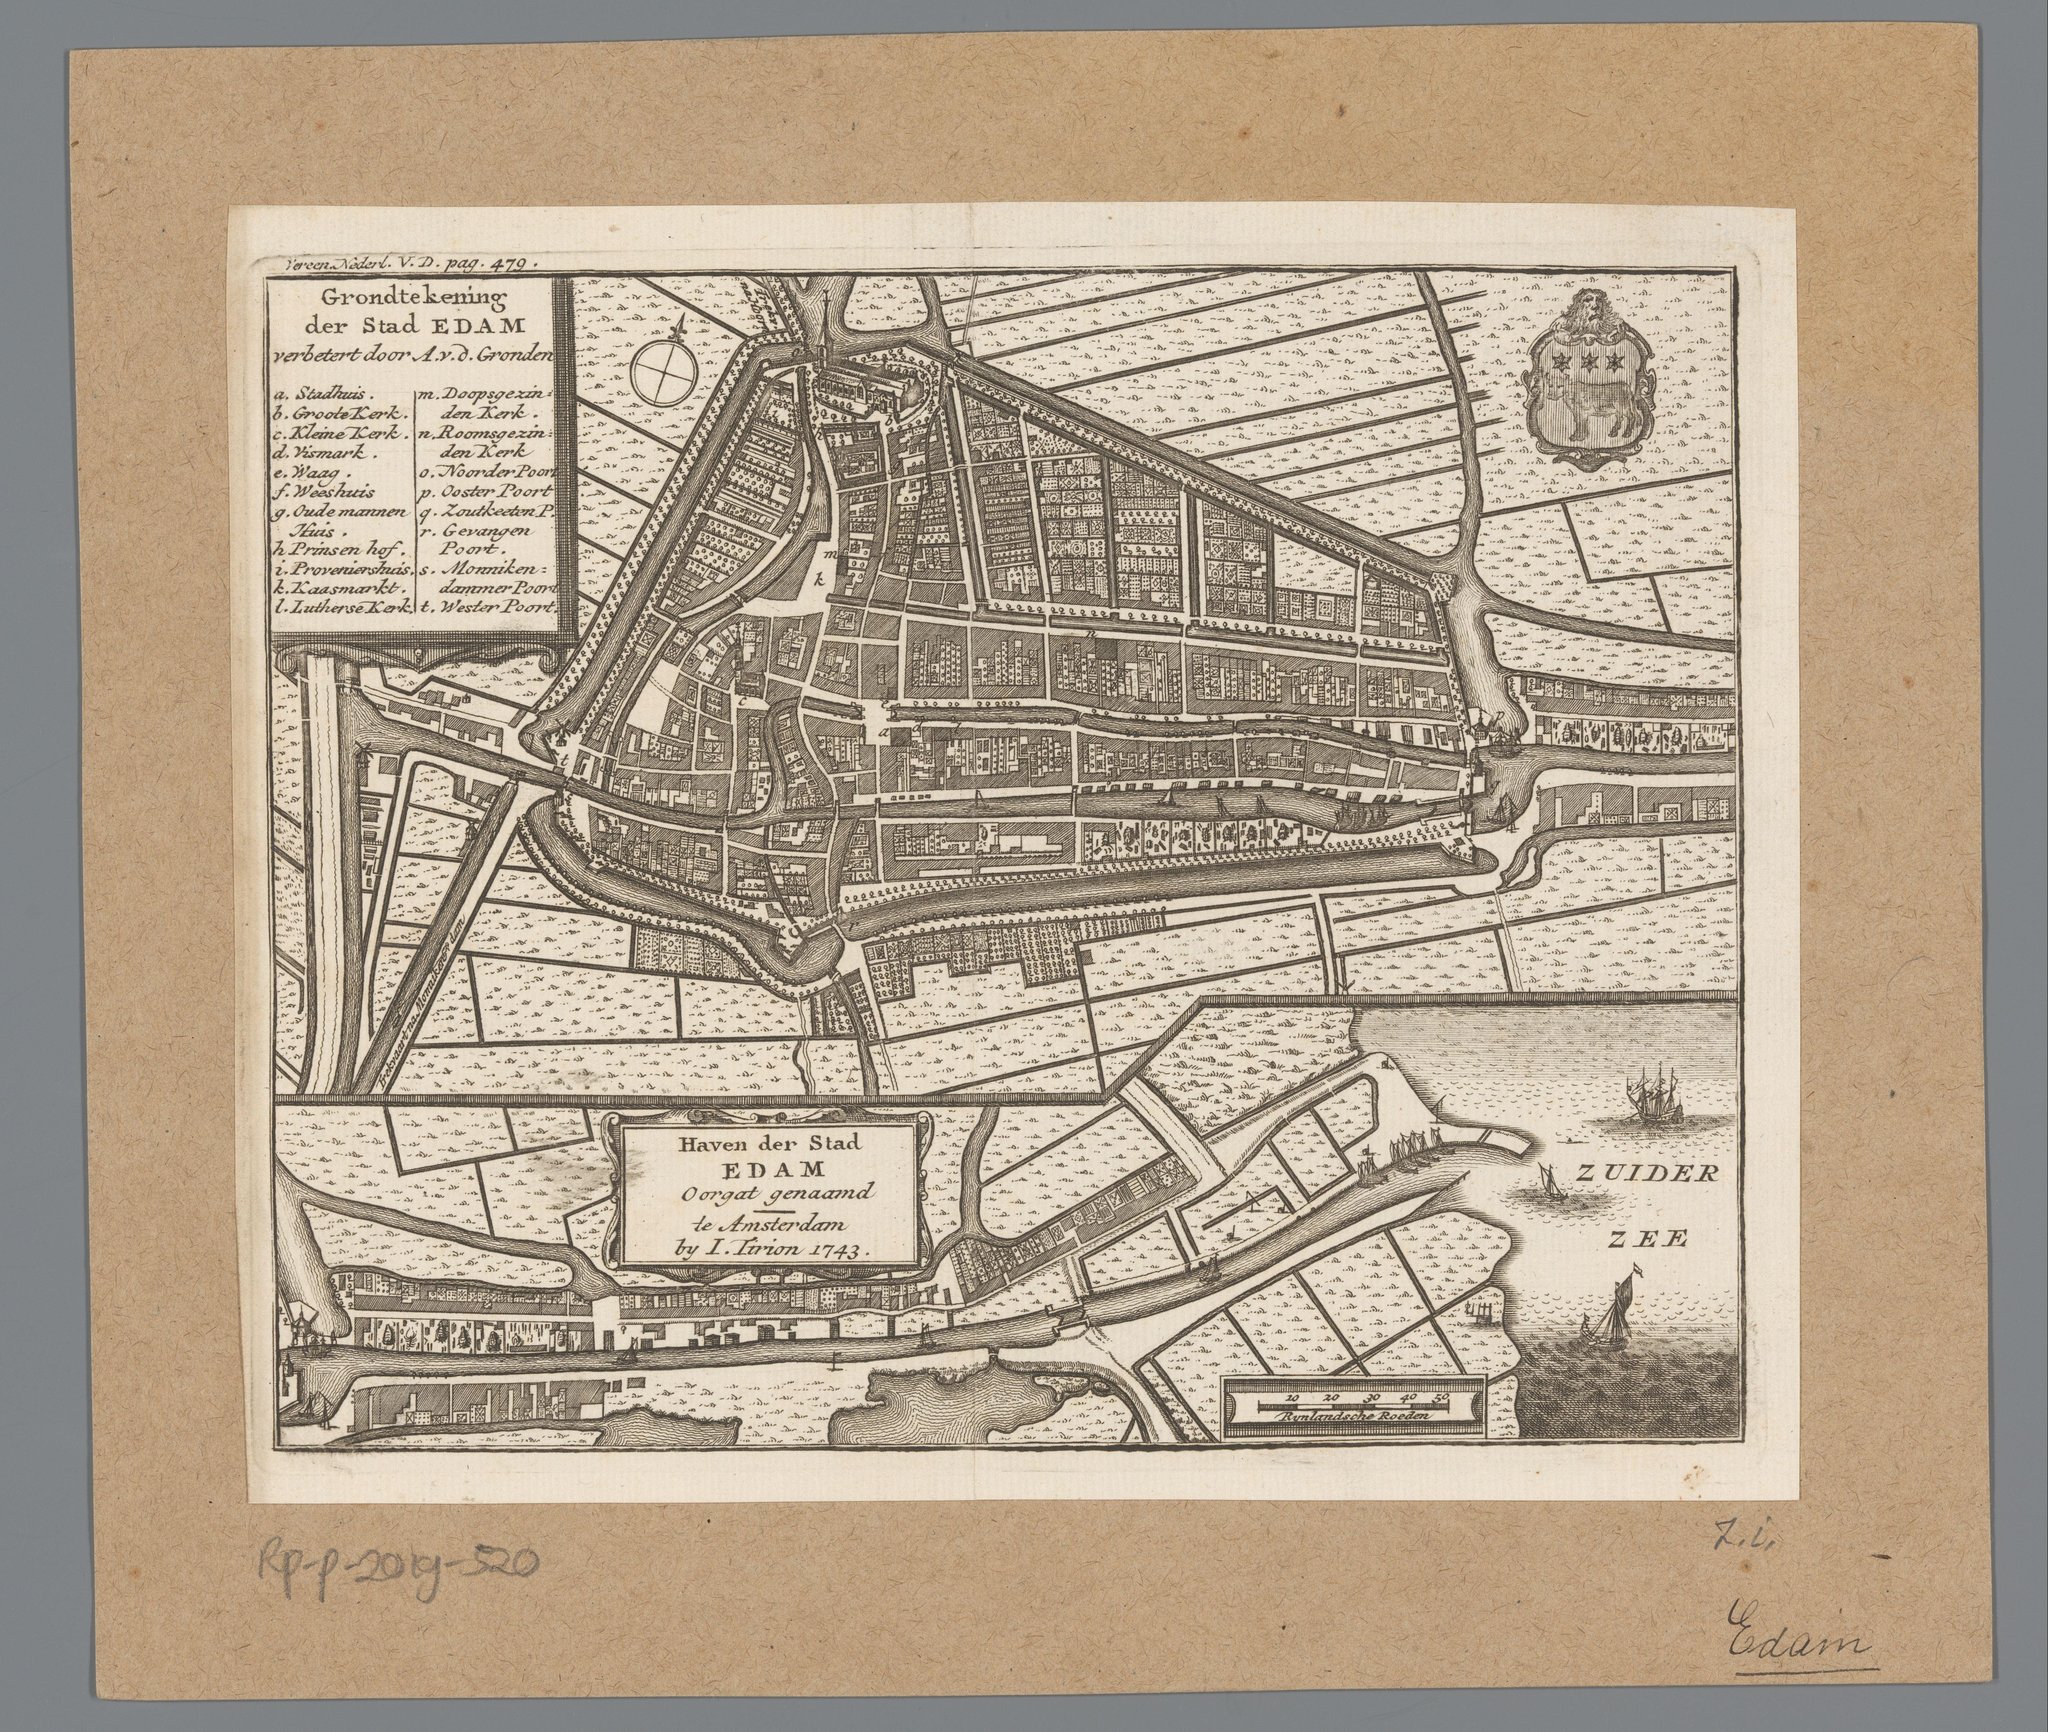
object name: print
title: Grondtekening der Stad Edam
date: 1743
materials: paper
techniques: etching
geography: amsterdam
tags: maps of cities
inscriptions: date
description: Prent uit: Tegenwoordige Staat der Vereenigde Nederlanden (...). Amsterdam: Isaak Tirion, 1744, dl. 5, p. 479.